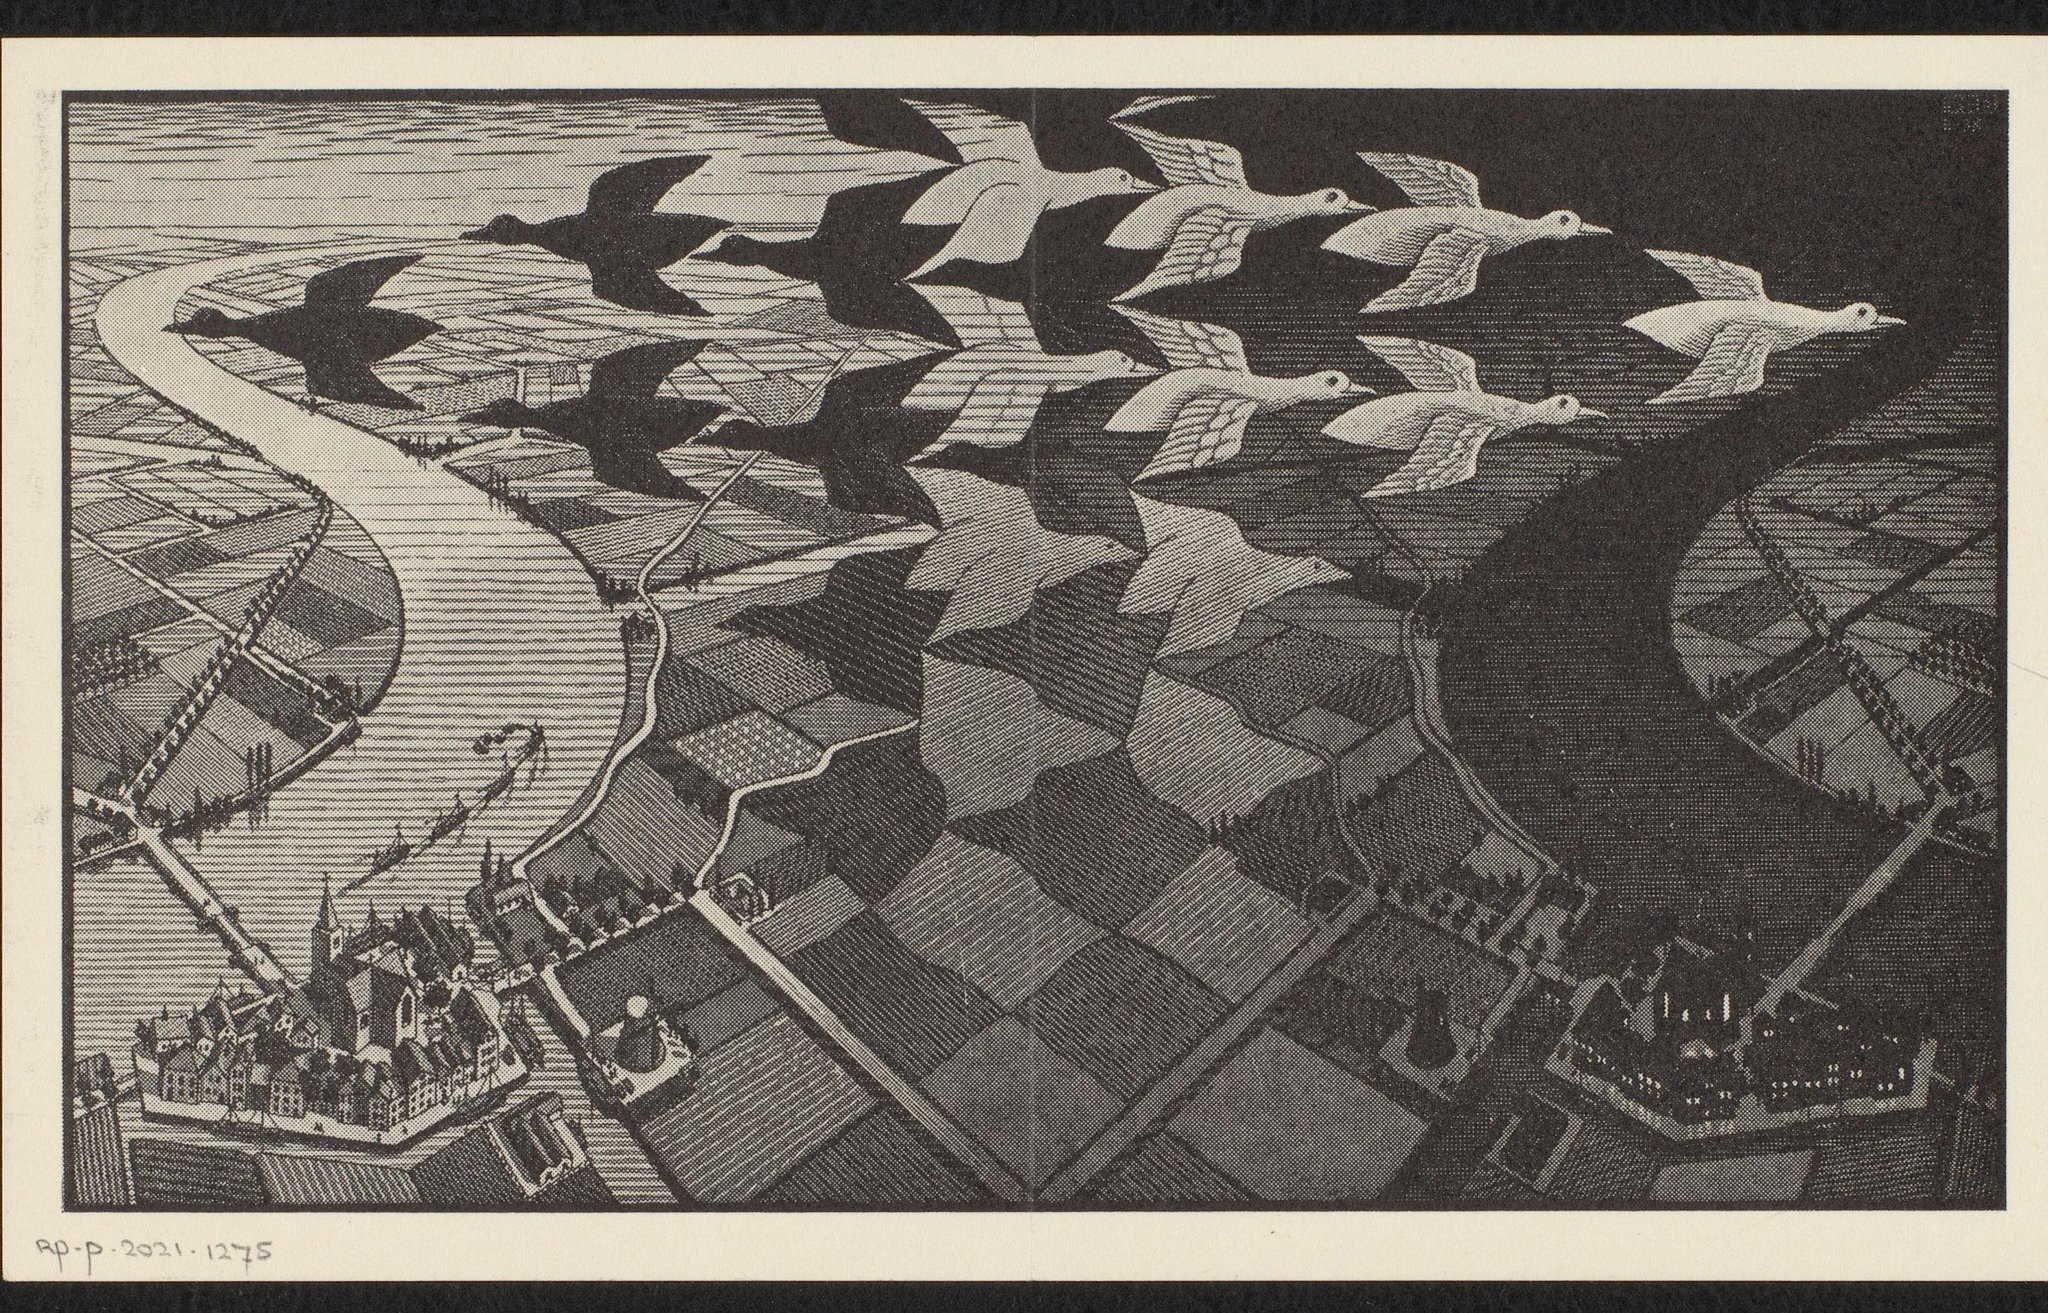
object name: photomechanical print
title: Prospectus voor de uitgave: P. Terpstra, Grafiek en tekeningen M.C. Escher, 1960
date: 1959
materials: paper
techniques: letterpress printing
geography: zwolle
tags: print, e.g.: engraving, etching, lithograph, day and night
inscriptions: stamp: ‘N.V. Martinus Nijhoff's boekhandel en uitgevers mij.’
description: Prospectus voor de genoemde publicatie. In het prospectus twee reproducties van grafische werken van Maurits Cornelis Escher: 'Relativiteit' (1953) en 'Dag en nacht' (1937).